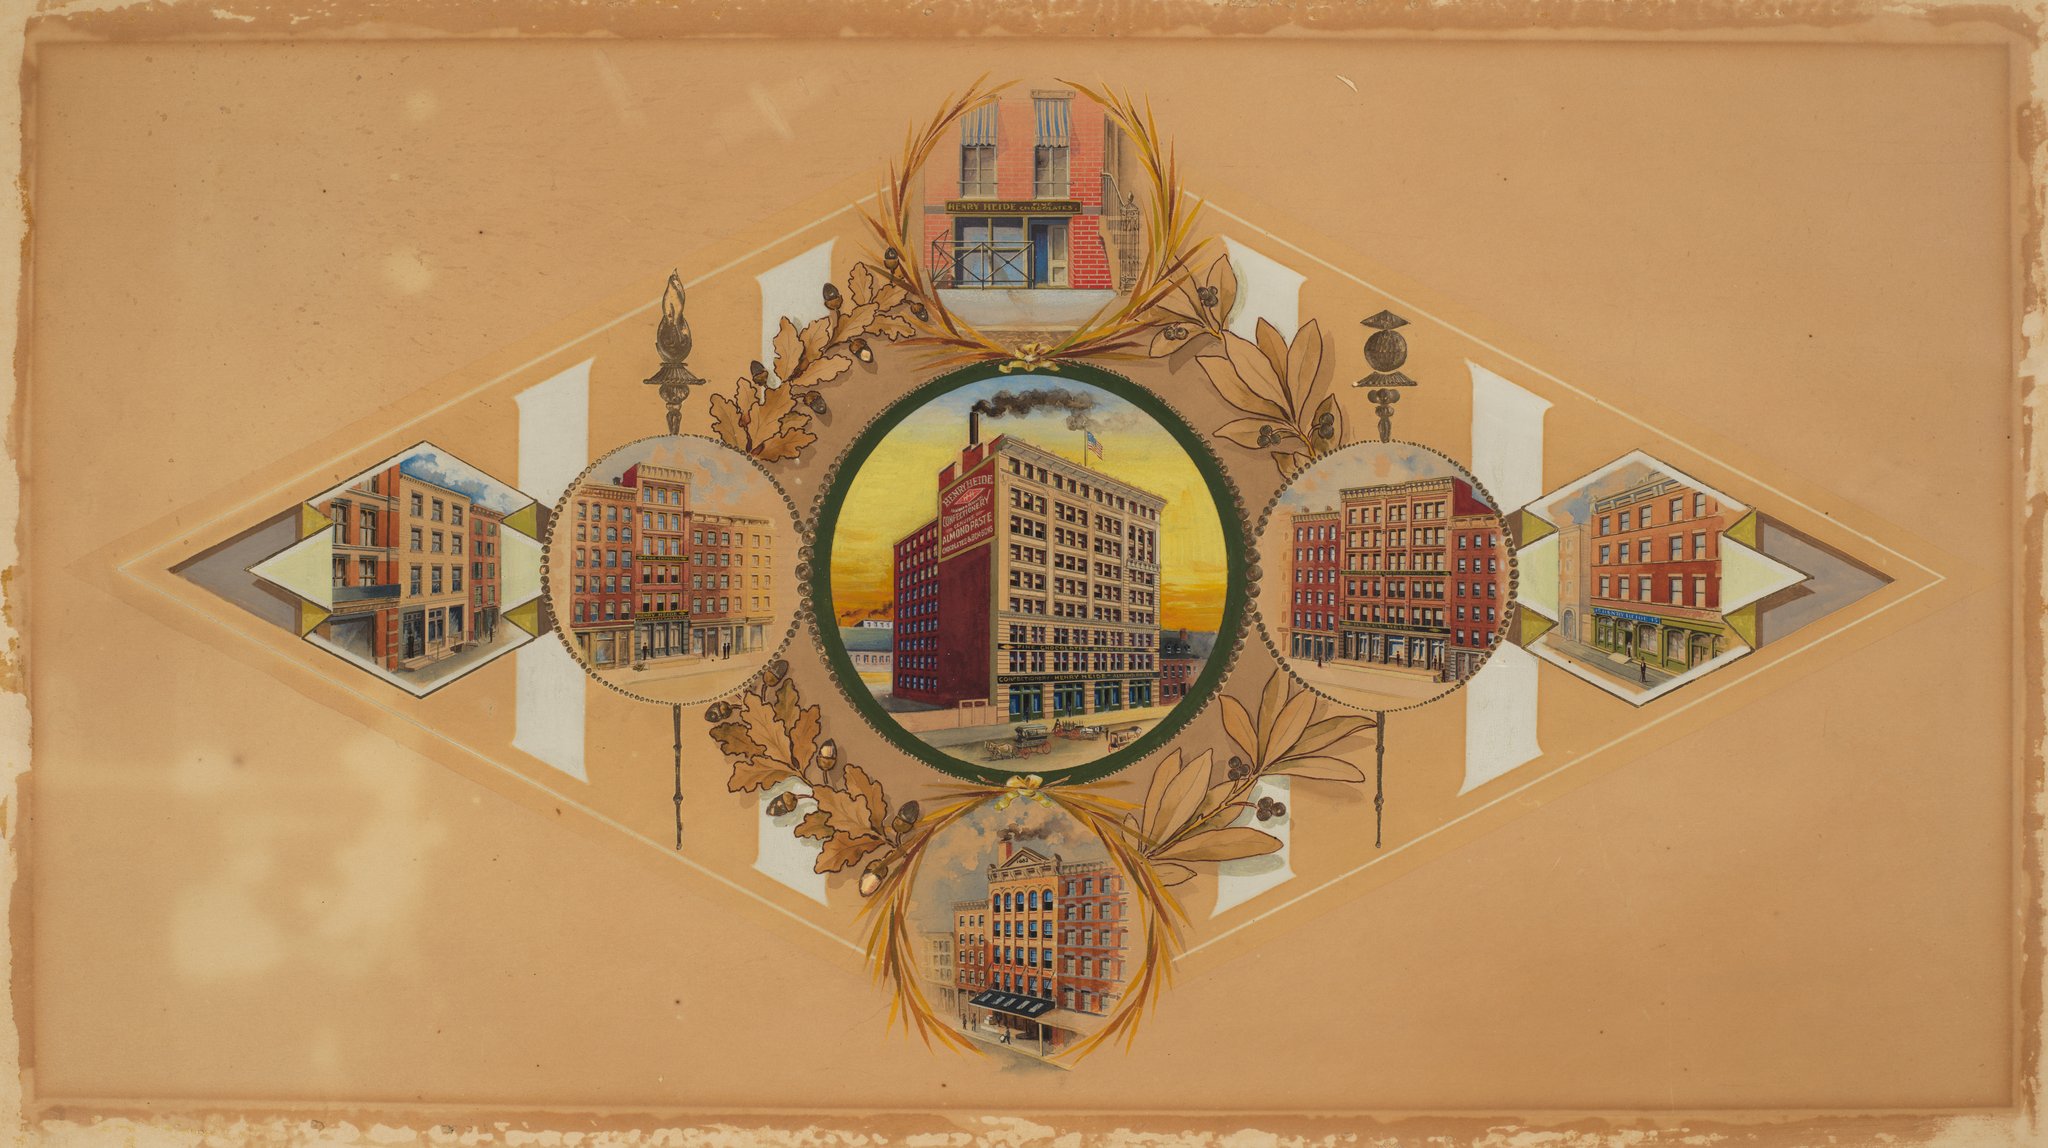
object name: drawing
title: Henry Heide Confectionary Co.– Seven Buildings Occupied by the Business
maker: anonymous, american, 19th century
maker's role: artist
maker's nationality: american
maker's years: 1800-1900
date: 1882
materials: watercolor